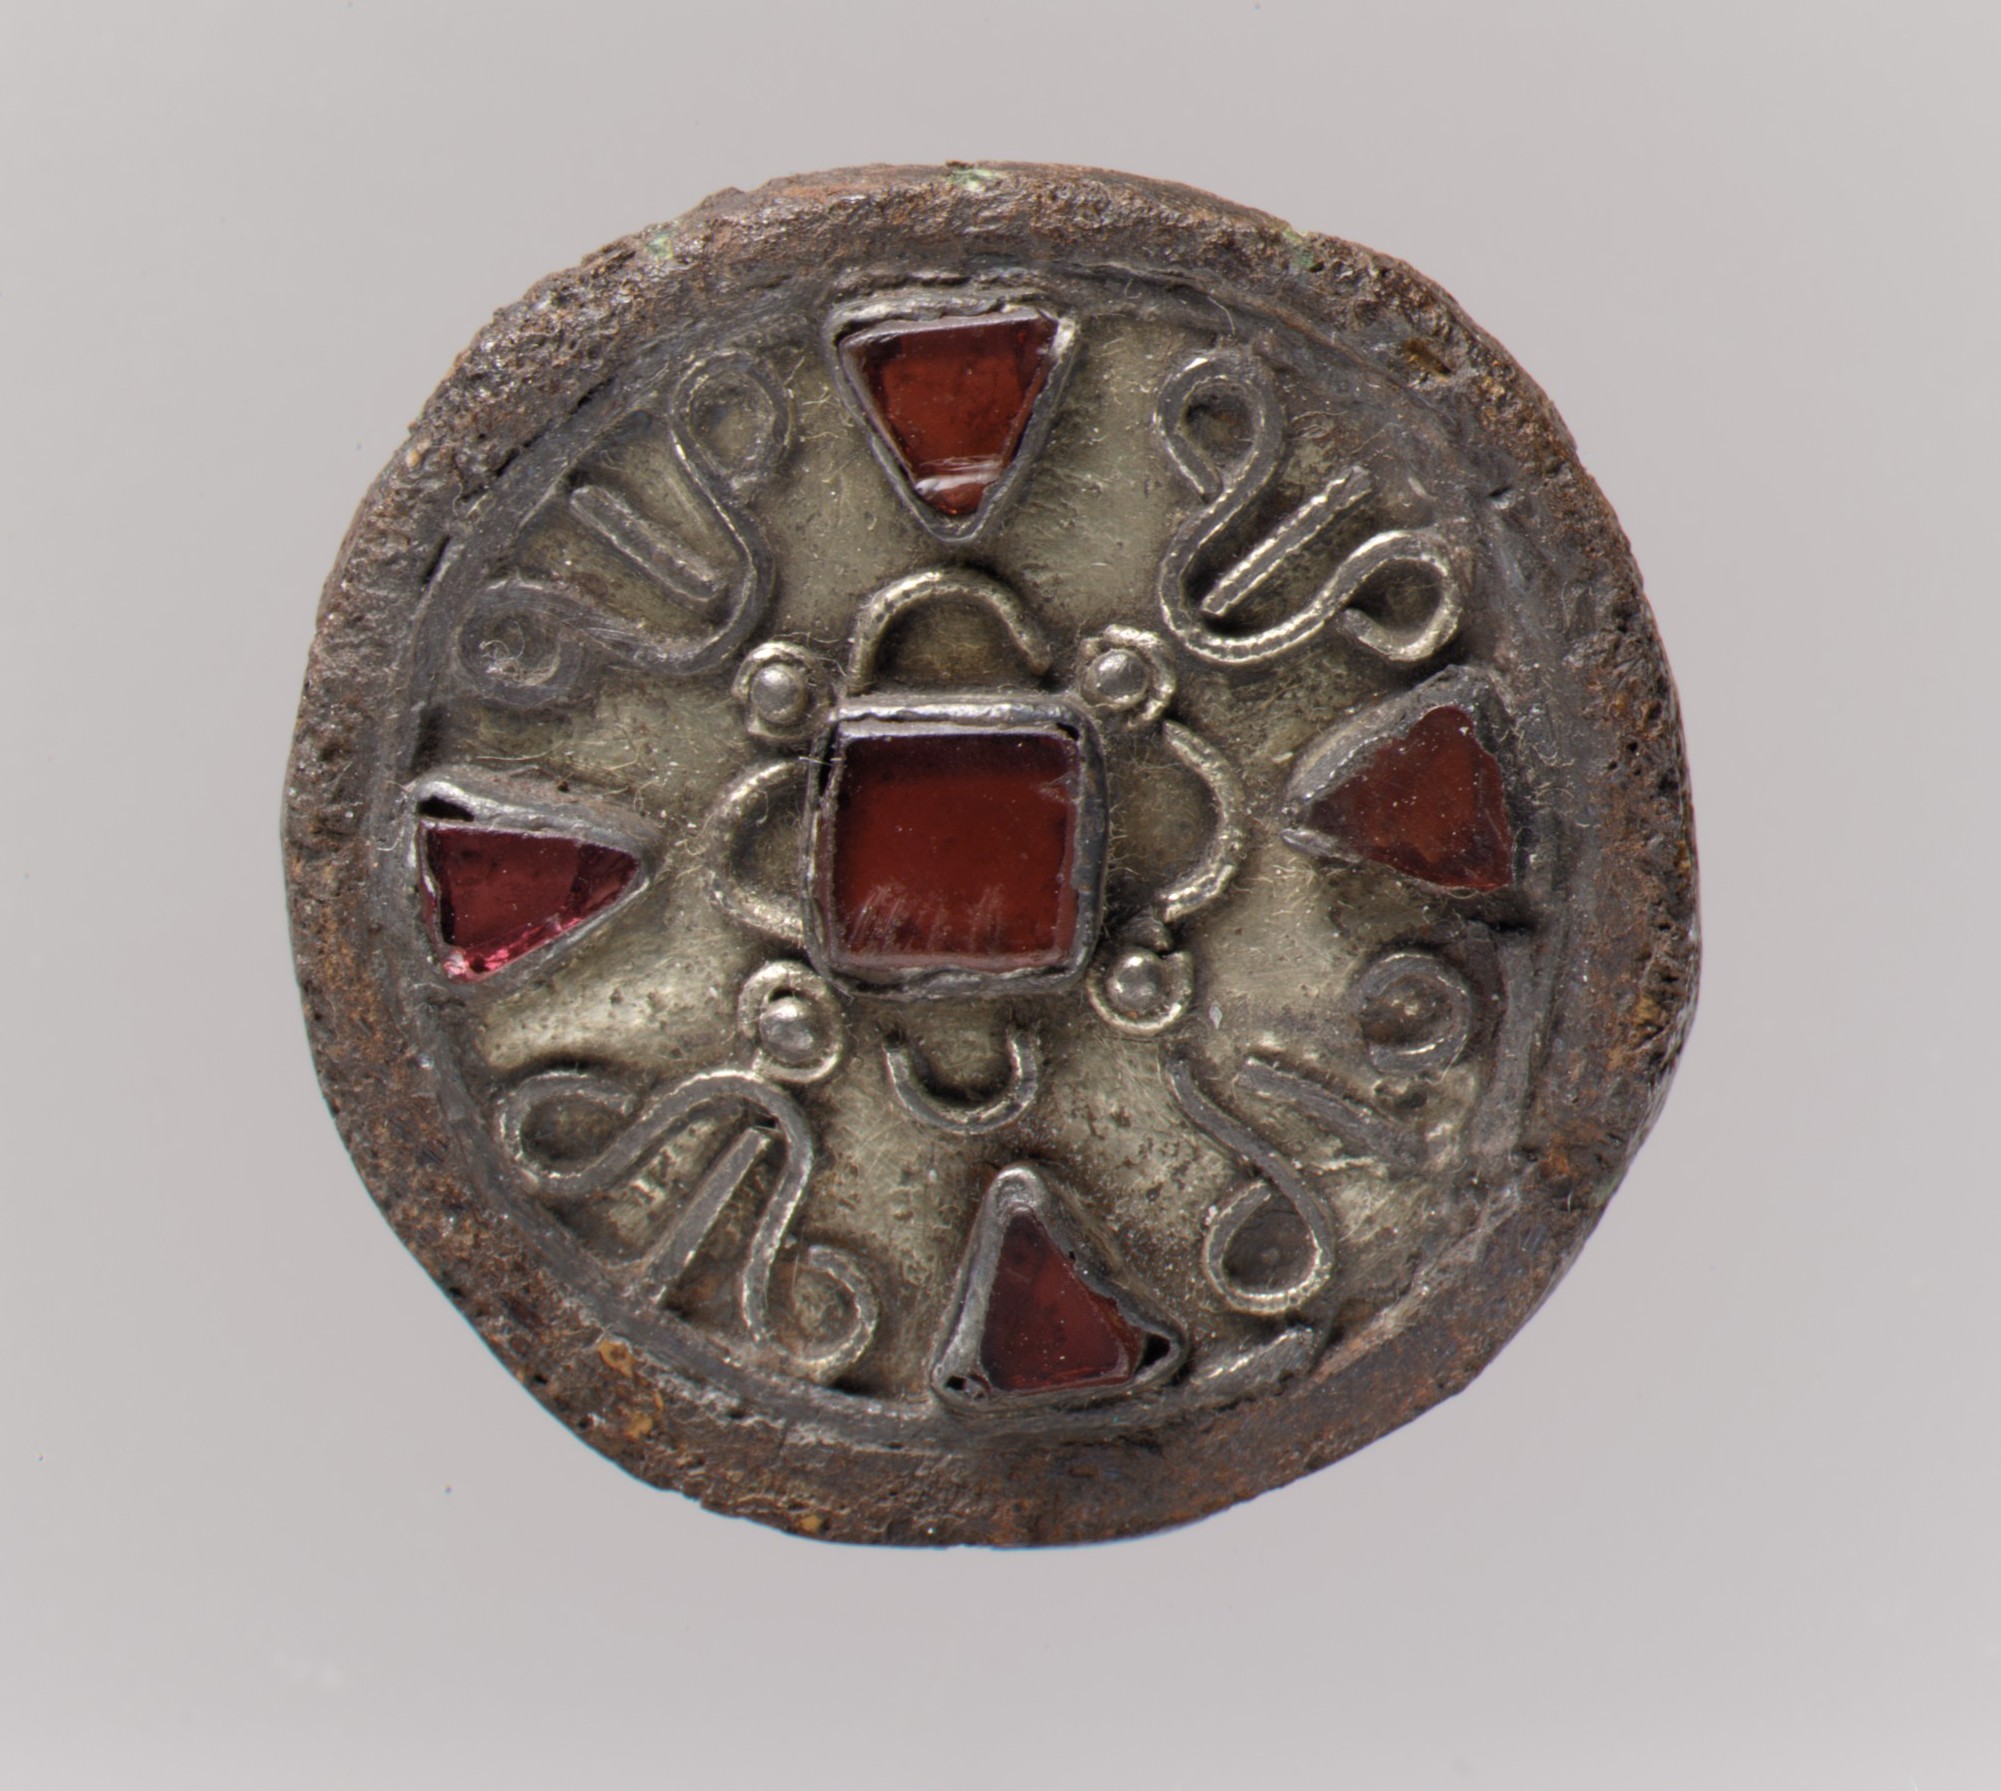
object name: brooch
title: Disk Brooch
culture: frankish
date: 601-633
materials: garnet, iron, silver gilt